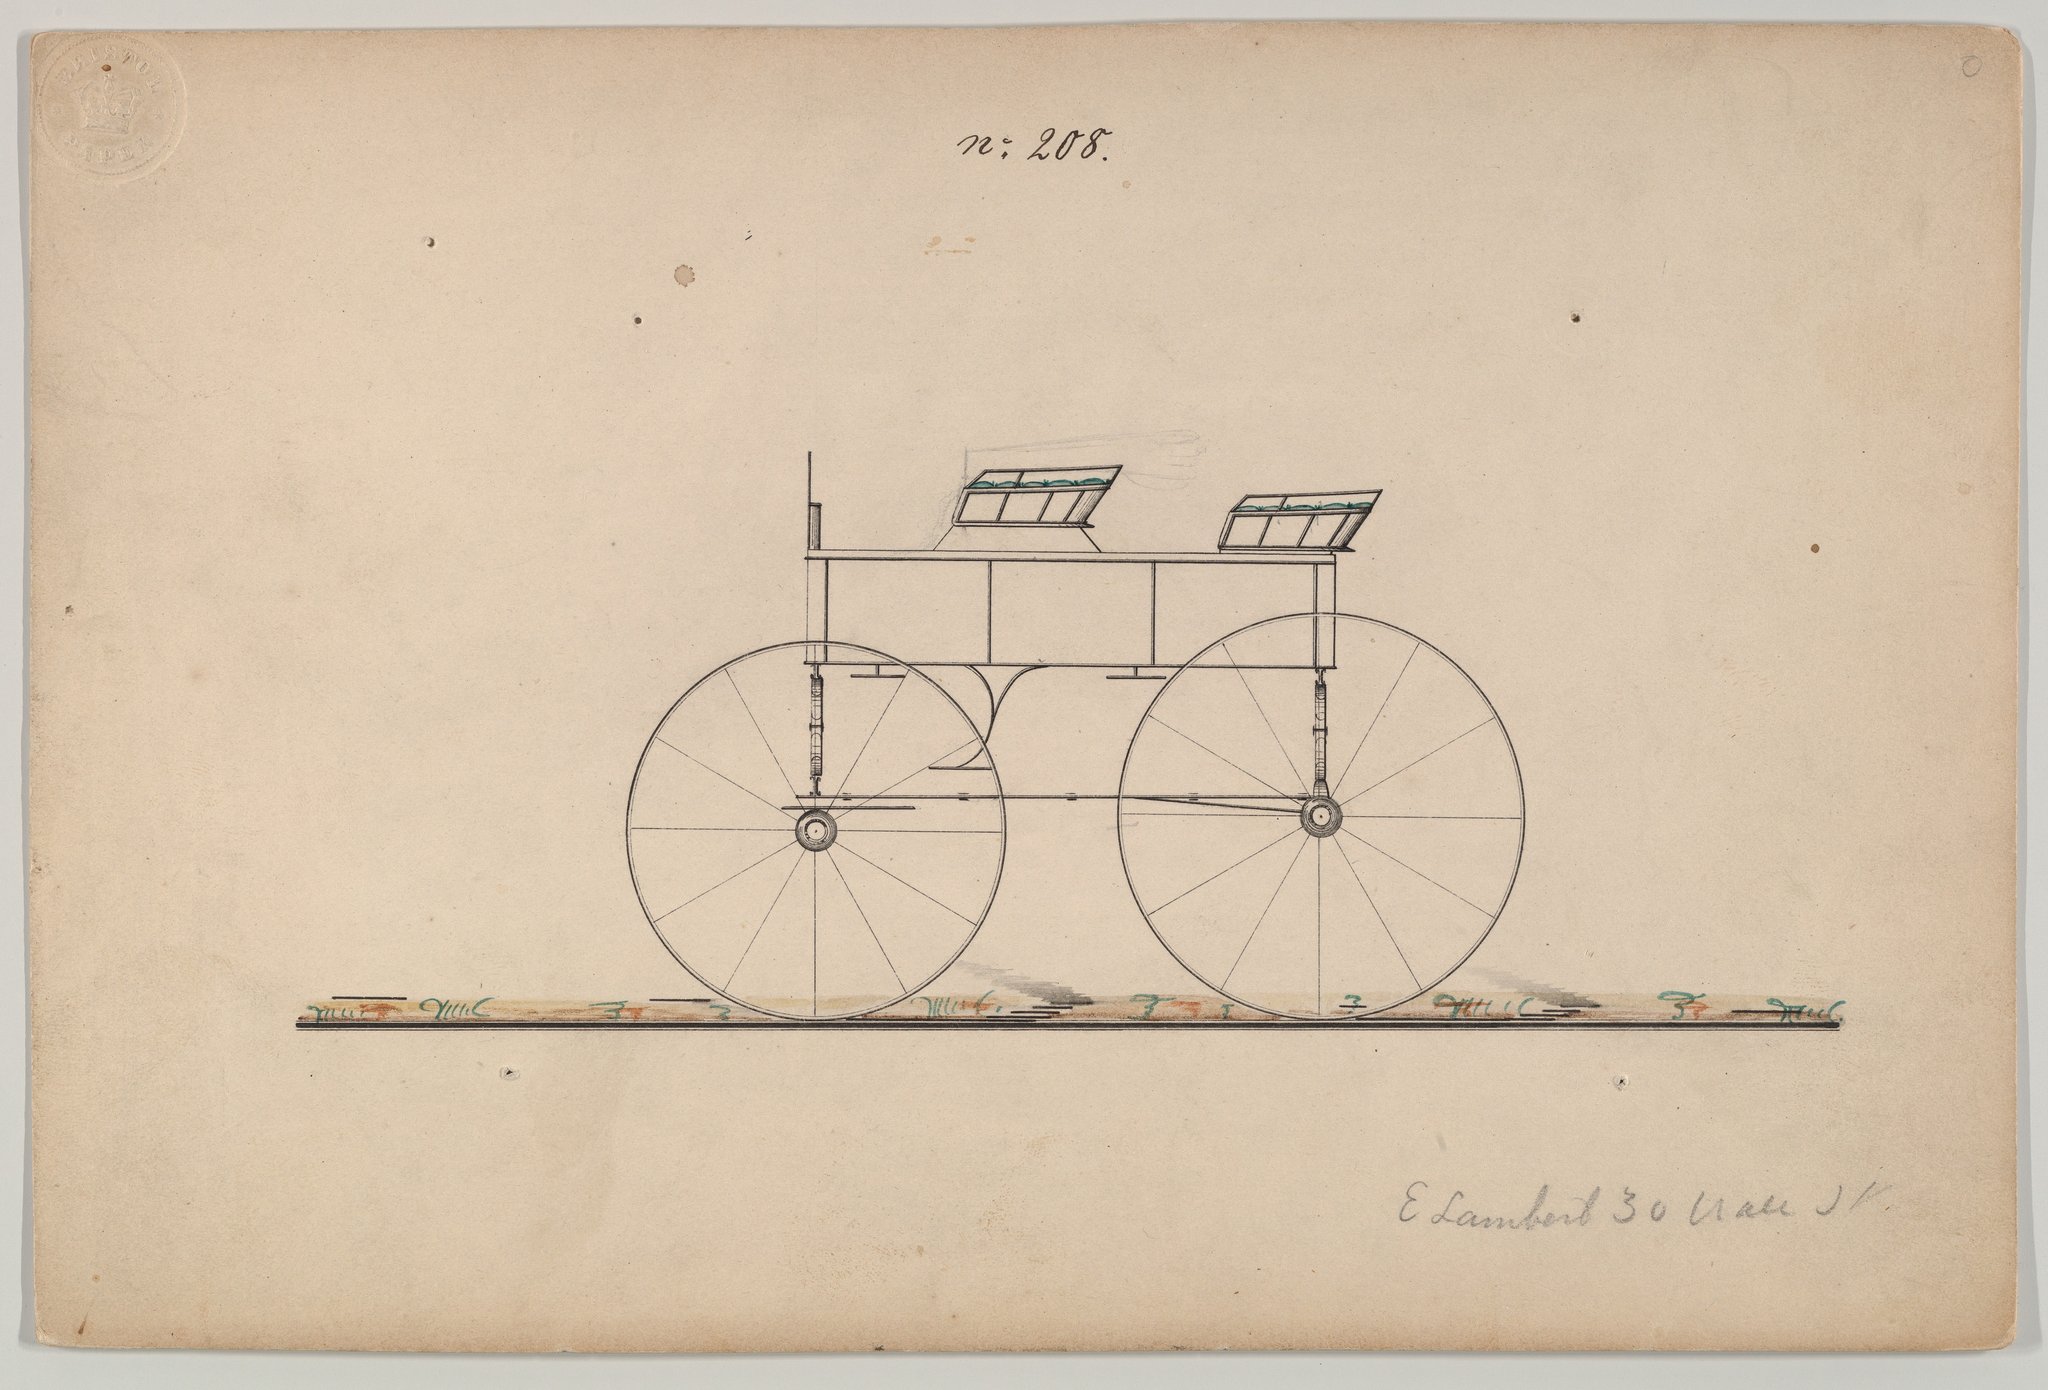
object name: drawing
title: Wagon # 208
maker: brewster & co.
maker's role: manufacturer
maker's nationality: american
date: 1850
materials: gouache, ink, watercolor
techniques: pen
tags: carriages